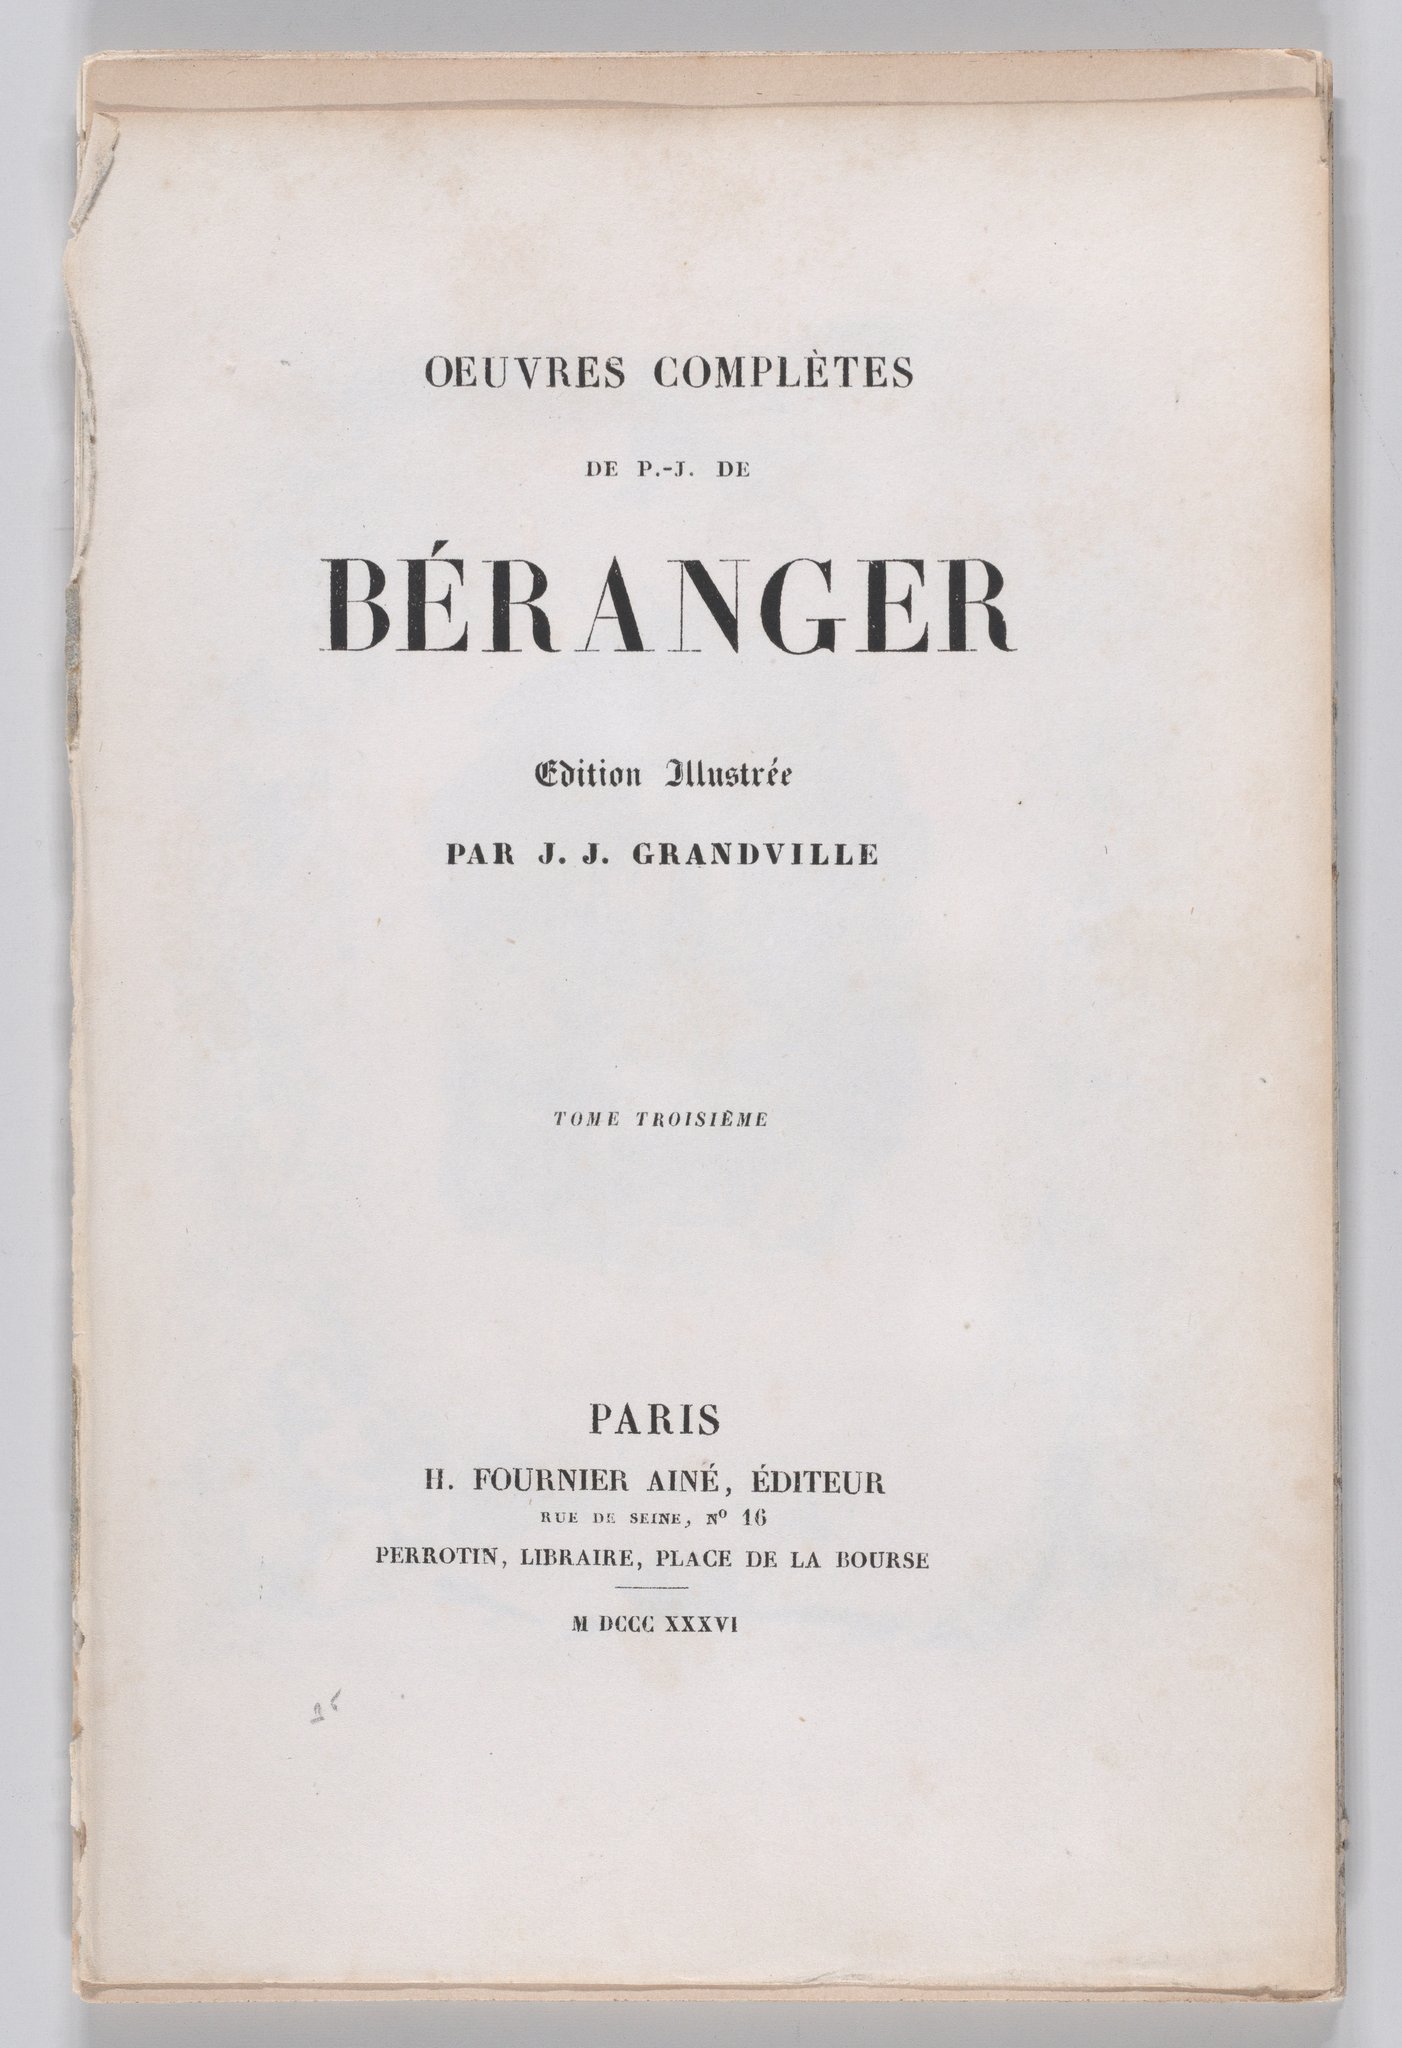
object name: print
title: The Complete Works of Béranger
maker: anonymous, french, 19th century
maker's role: artist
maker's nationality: french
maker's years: 1800-1900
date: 1836